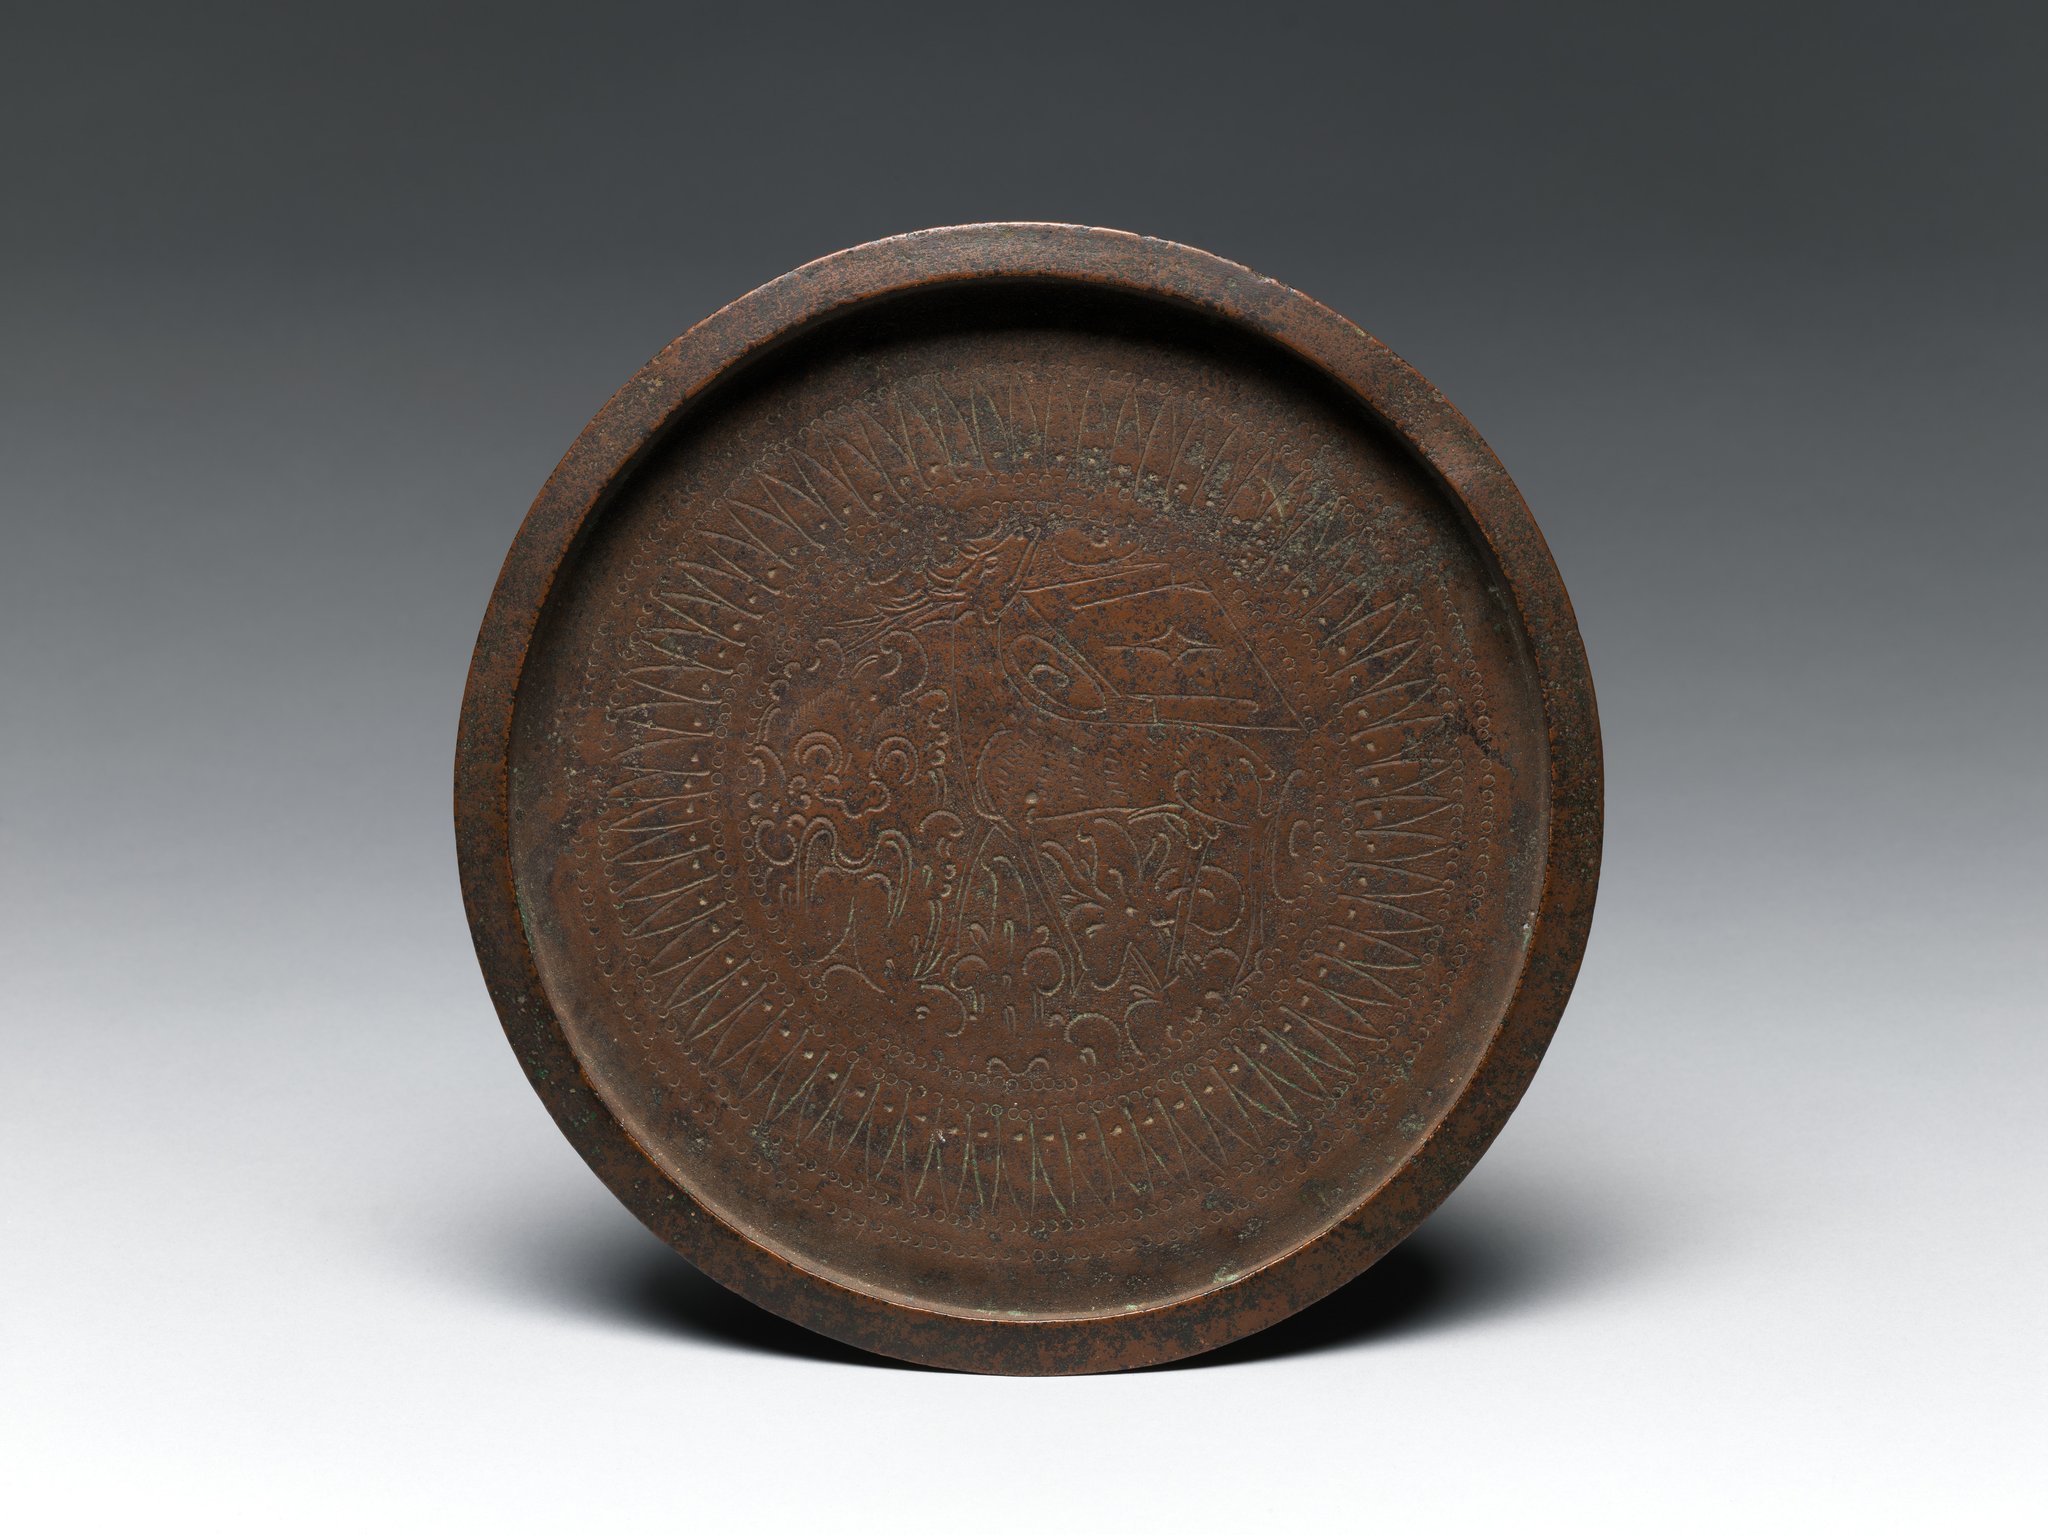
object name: offering tray talam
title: Offering Tray (Talam)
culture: indonesian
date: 901-1400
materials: bronze